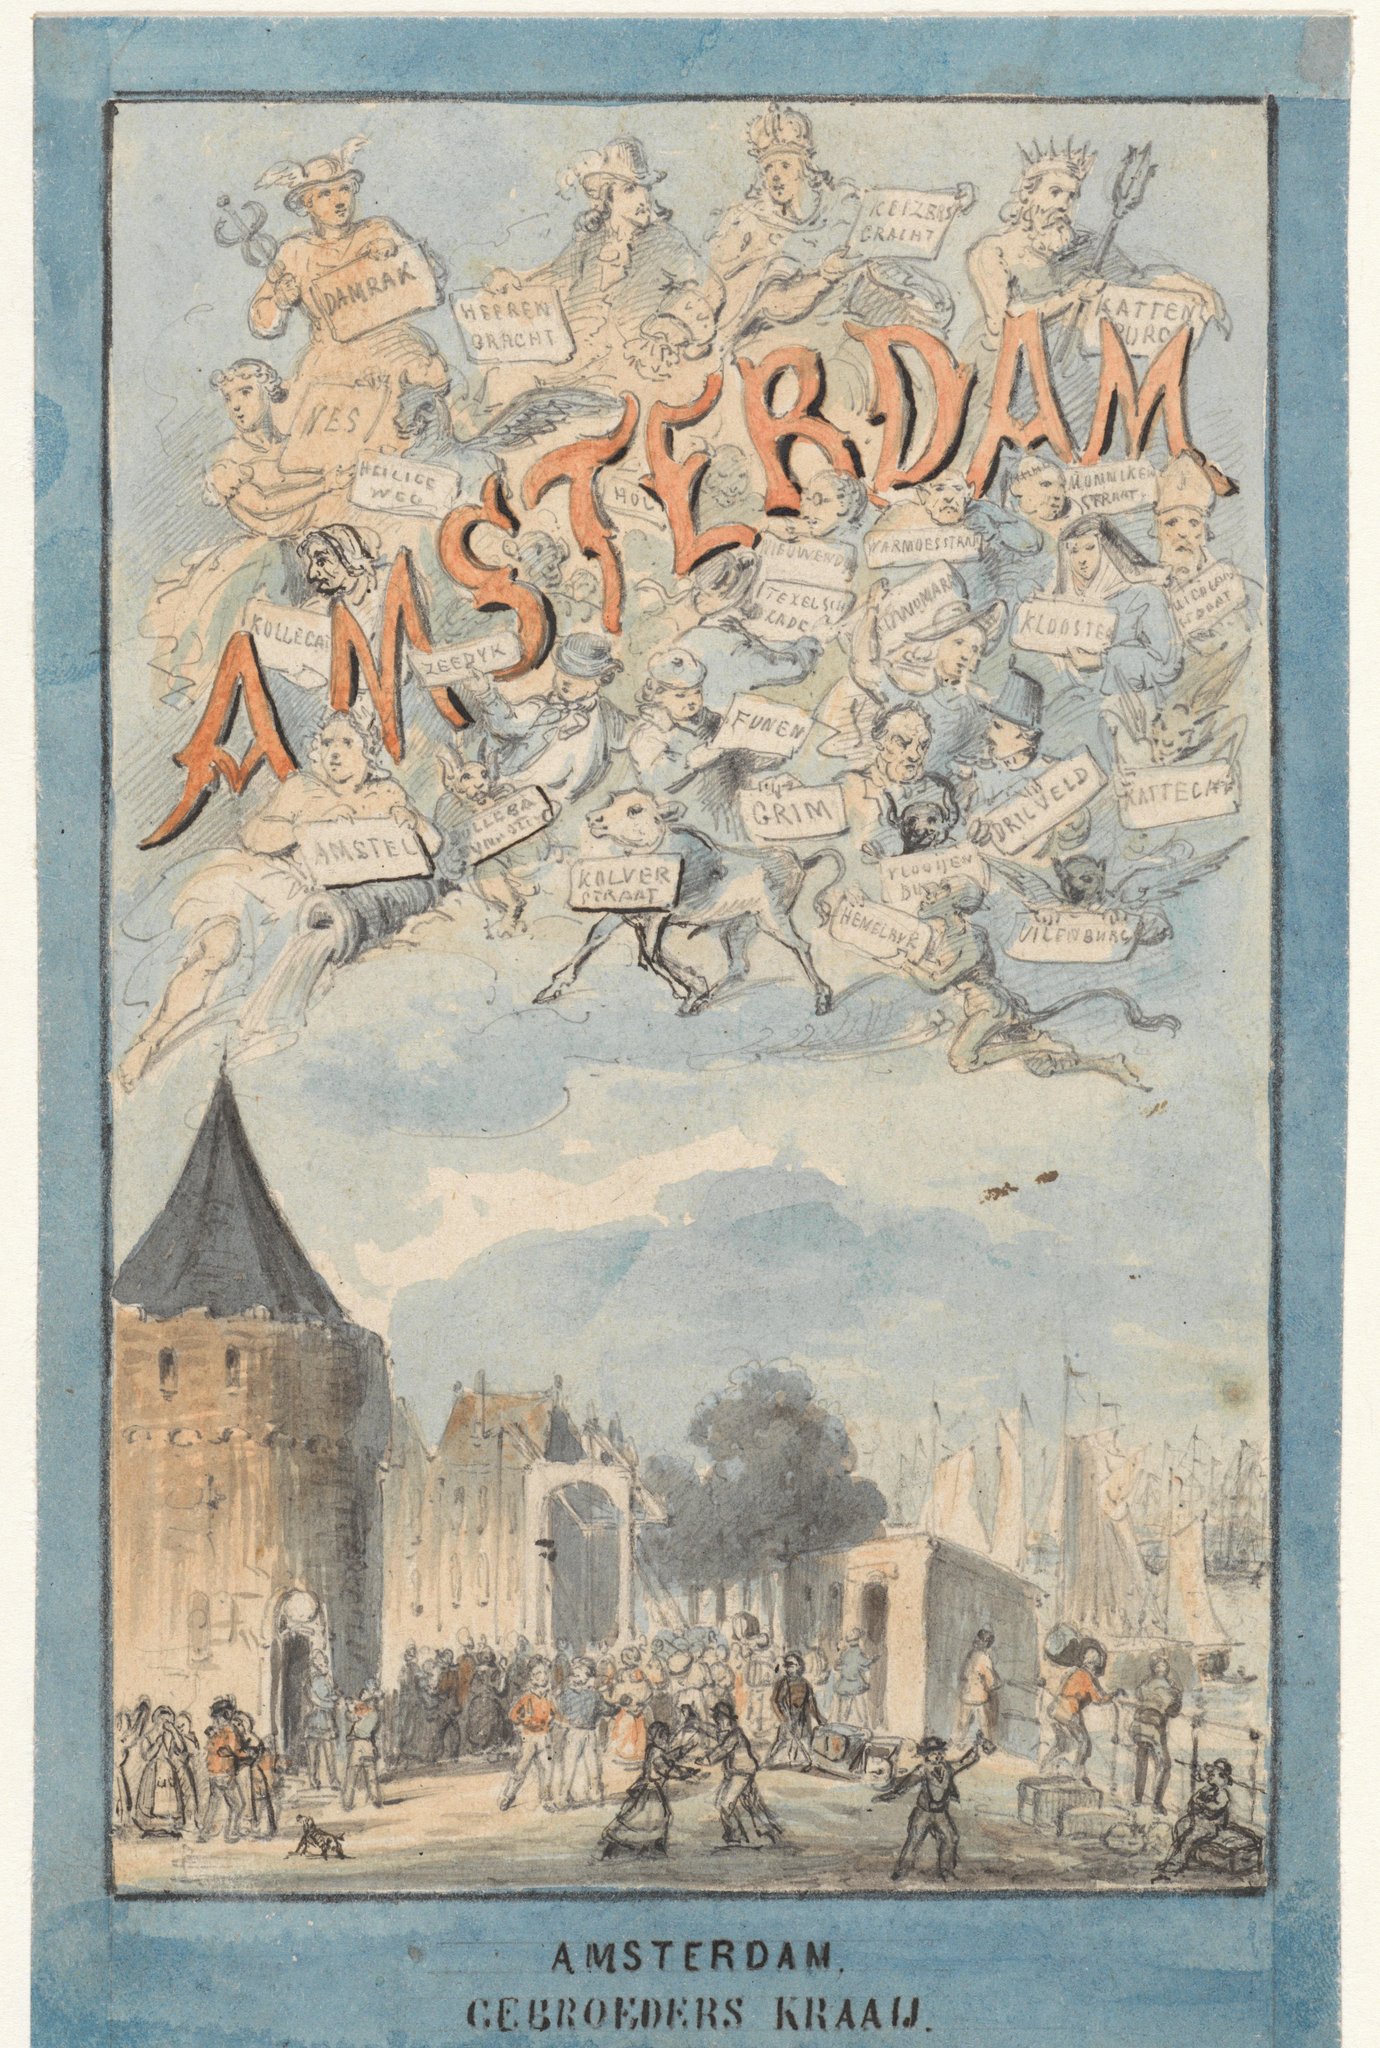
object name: design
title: Ontwerp voor de omslag van het boek Amsterdam. Oorsprong en afleiding van de namen der grachten (...), van Johannes ter Gouw, 1858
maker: johan coenraad leich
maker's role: draughtsman, print maker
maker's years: 1823-1890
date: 1853-1858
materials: ink, paper, pencil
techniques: brush, pen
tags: (ter gouw, amsterdam. oorsprong en afleiding van de namen) specific works of literature (with author, title), public road, amsterdam